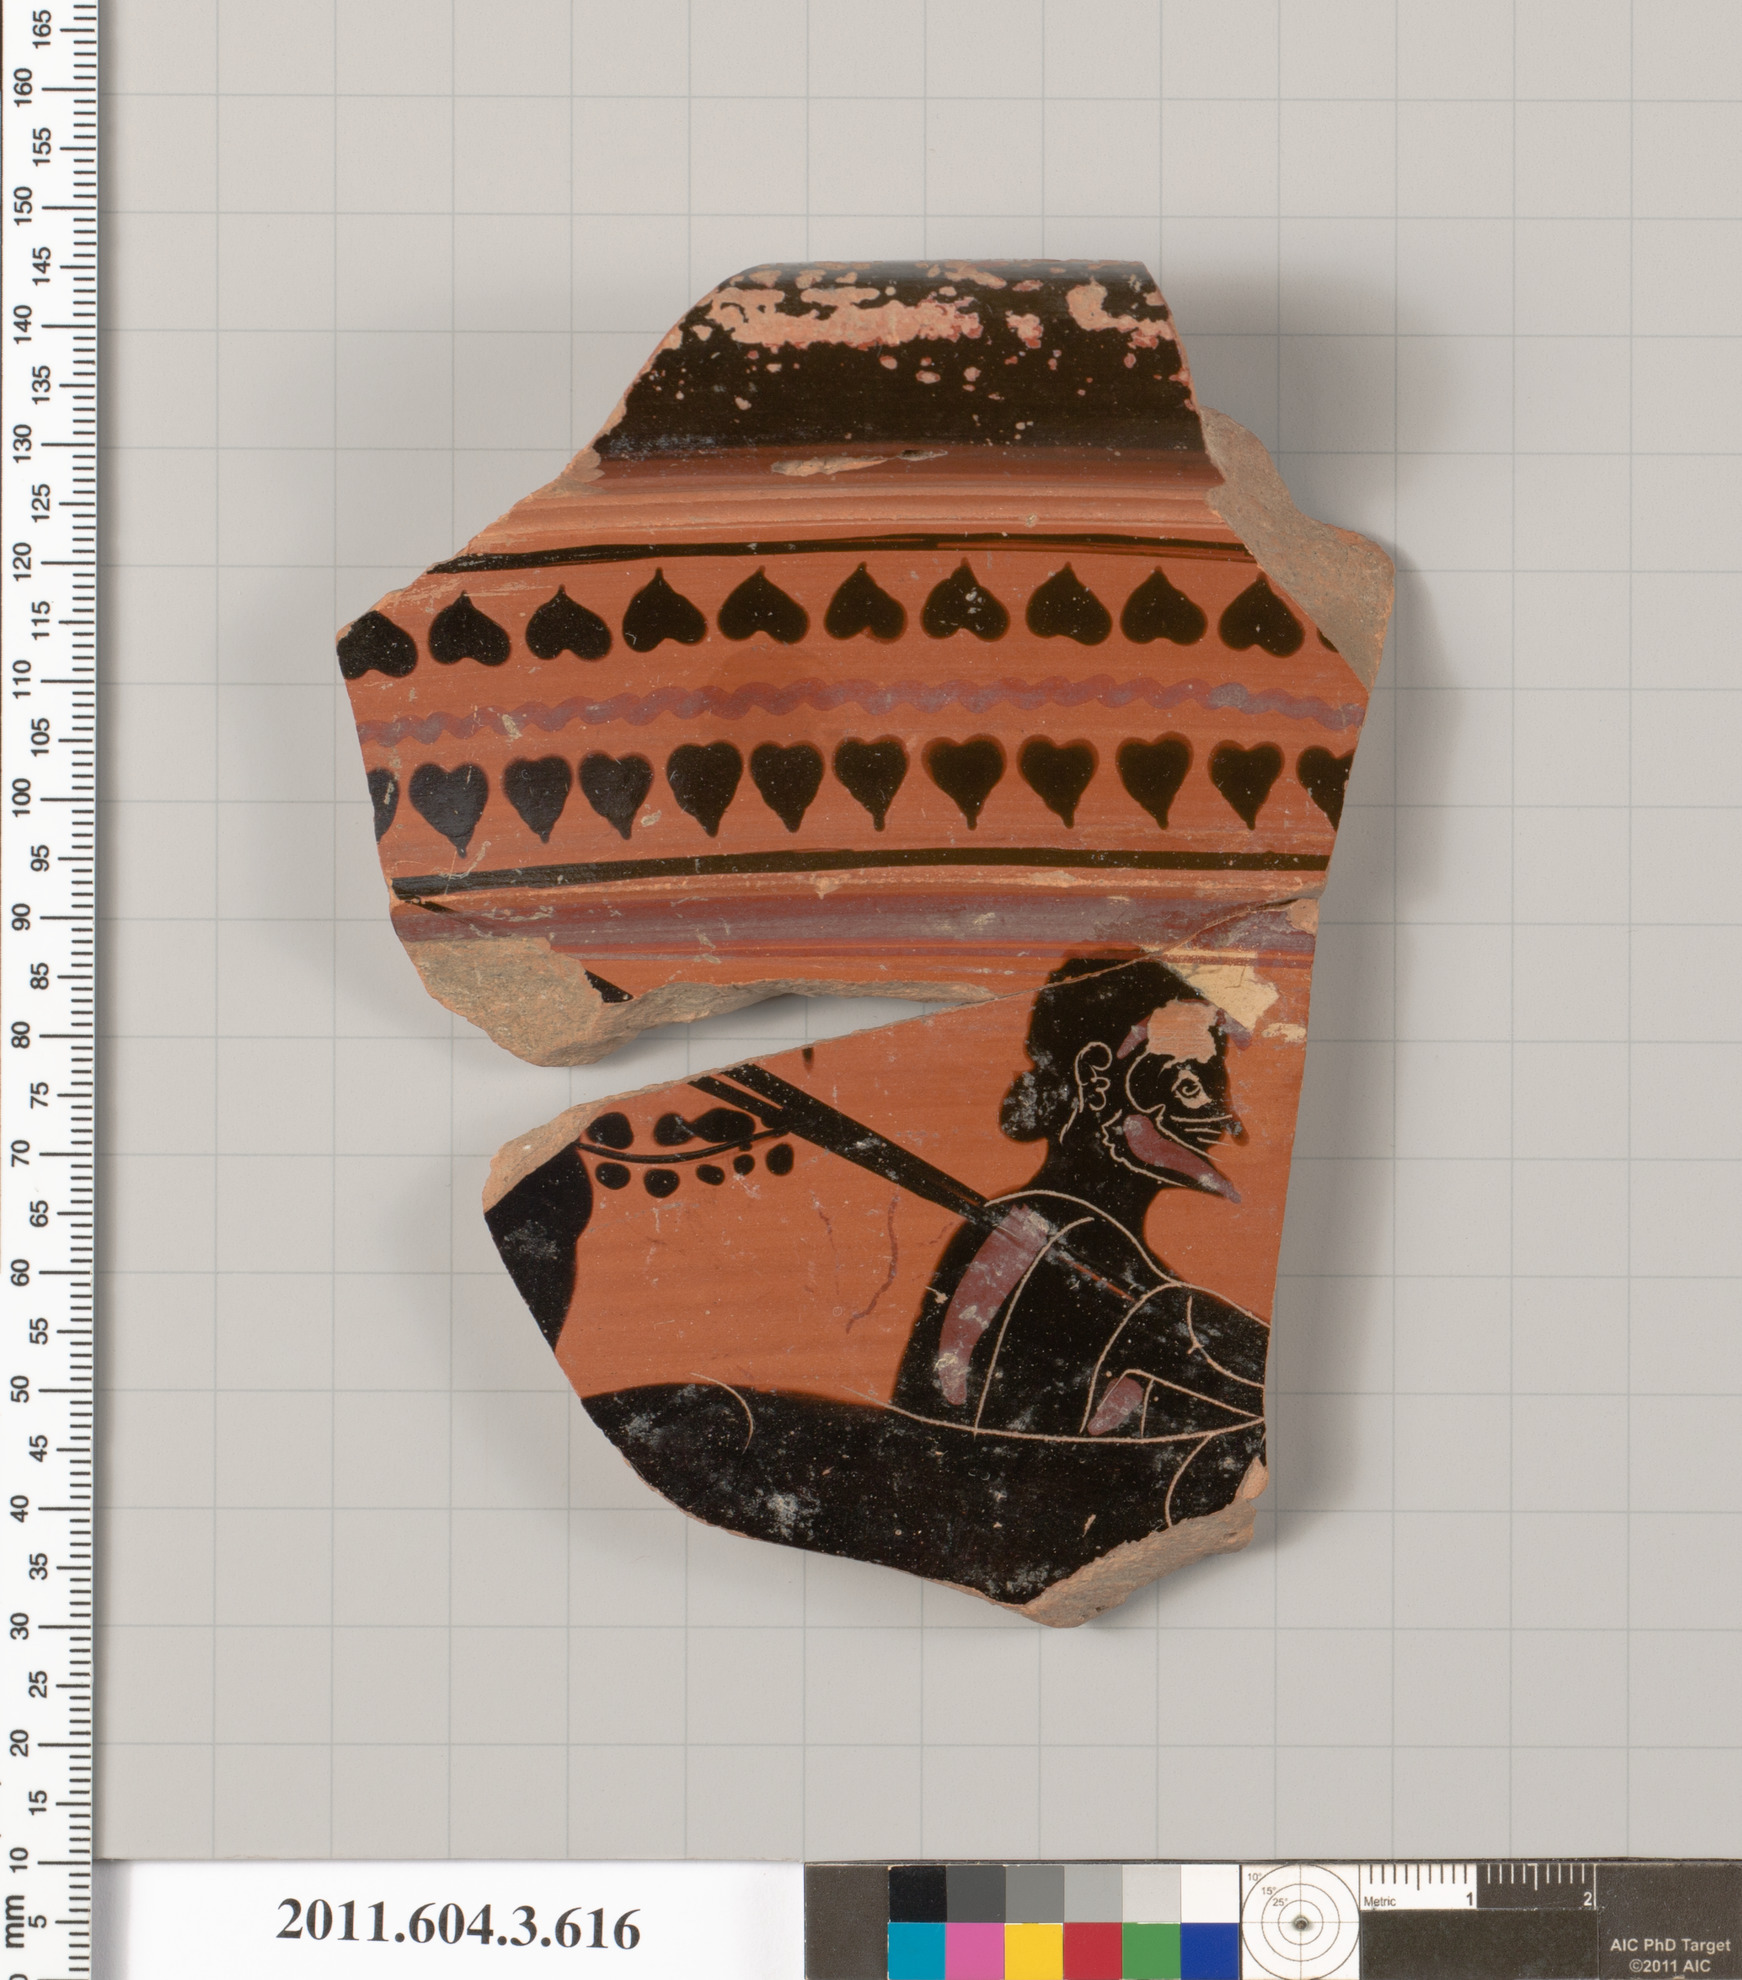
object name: calyx krater fragment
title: Terracotta fragment of a calyx-krater (bowl for mixing wine and water)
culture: greek, attic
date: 550-526 BCE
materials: terracotta